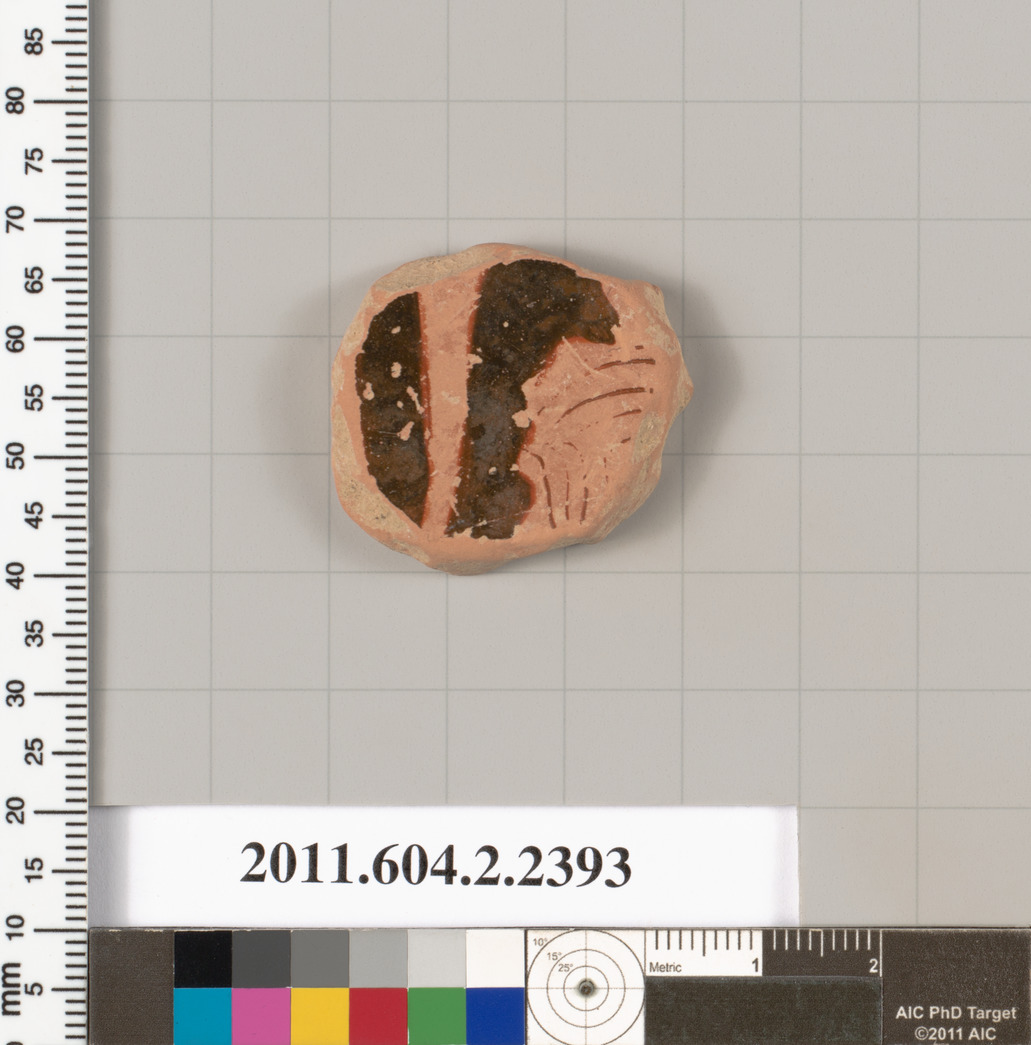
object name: pot fragment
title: Terracotta fragments of a pot; glazed on the inside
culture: greek, attic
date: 434-368 BCE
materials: terracotta